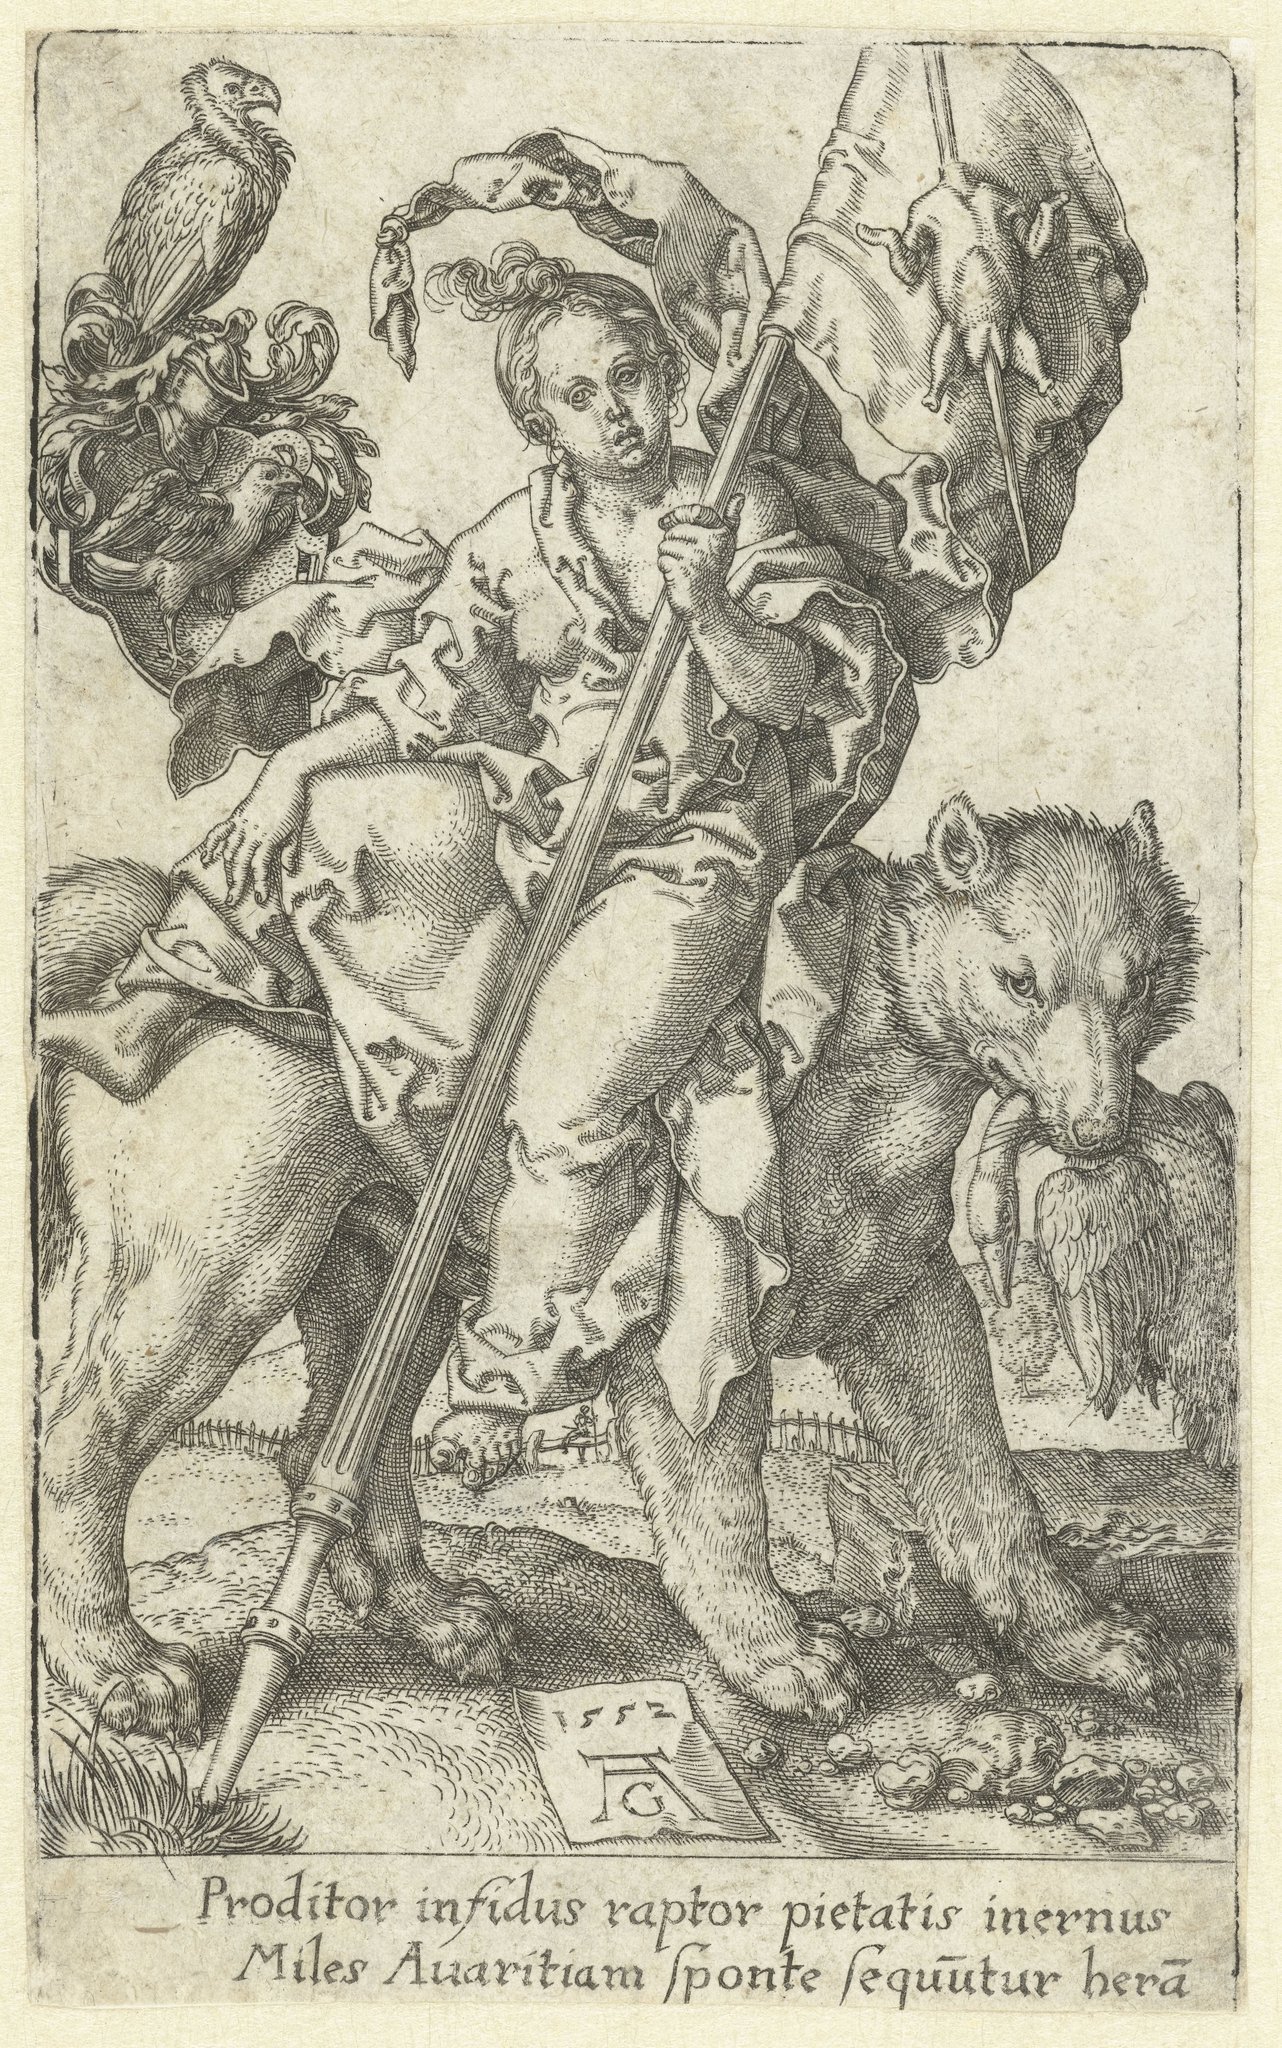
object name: print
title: Zeven Hoofdzonden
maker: heinrich aldegrever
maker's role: draughtsman, print maker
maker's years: 1502-1561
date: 1552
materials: paper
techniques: engraving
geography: germany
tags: covetousness; 'avaritia' (ripa) ~ personification of one of the seven deadly sins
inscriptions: collector's mark: Lugt 11, collector's mark: ‘Hinloopen’ Lugt 11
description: Personificatie van hebzucht. Vrouw zittend op een wolf met een gans in zijn bek. In haar linkerhand een vaandel met een afbeelding van een kip op een spies. Linksboven een wapenschild met een vogel, daarboven een gier. Onder de voorstelling een tweeregelige tekst in het Latijn. Vijfde prent uit een serie van zeven.